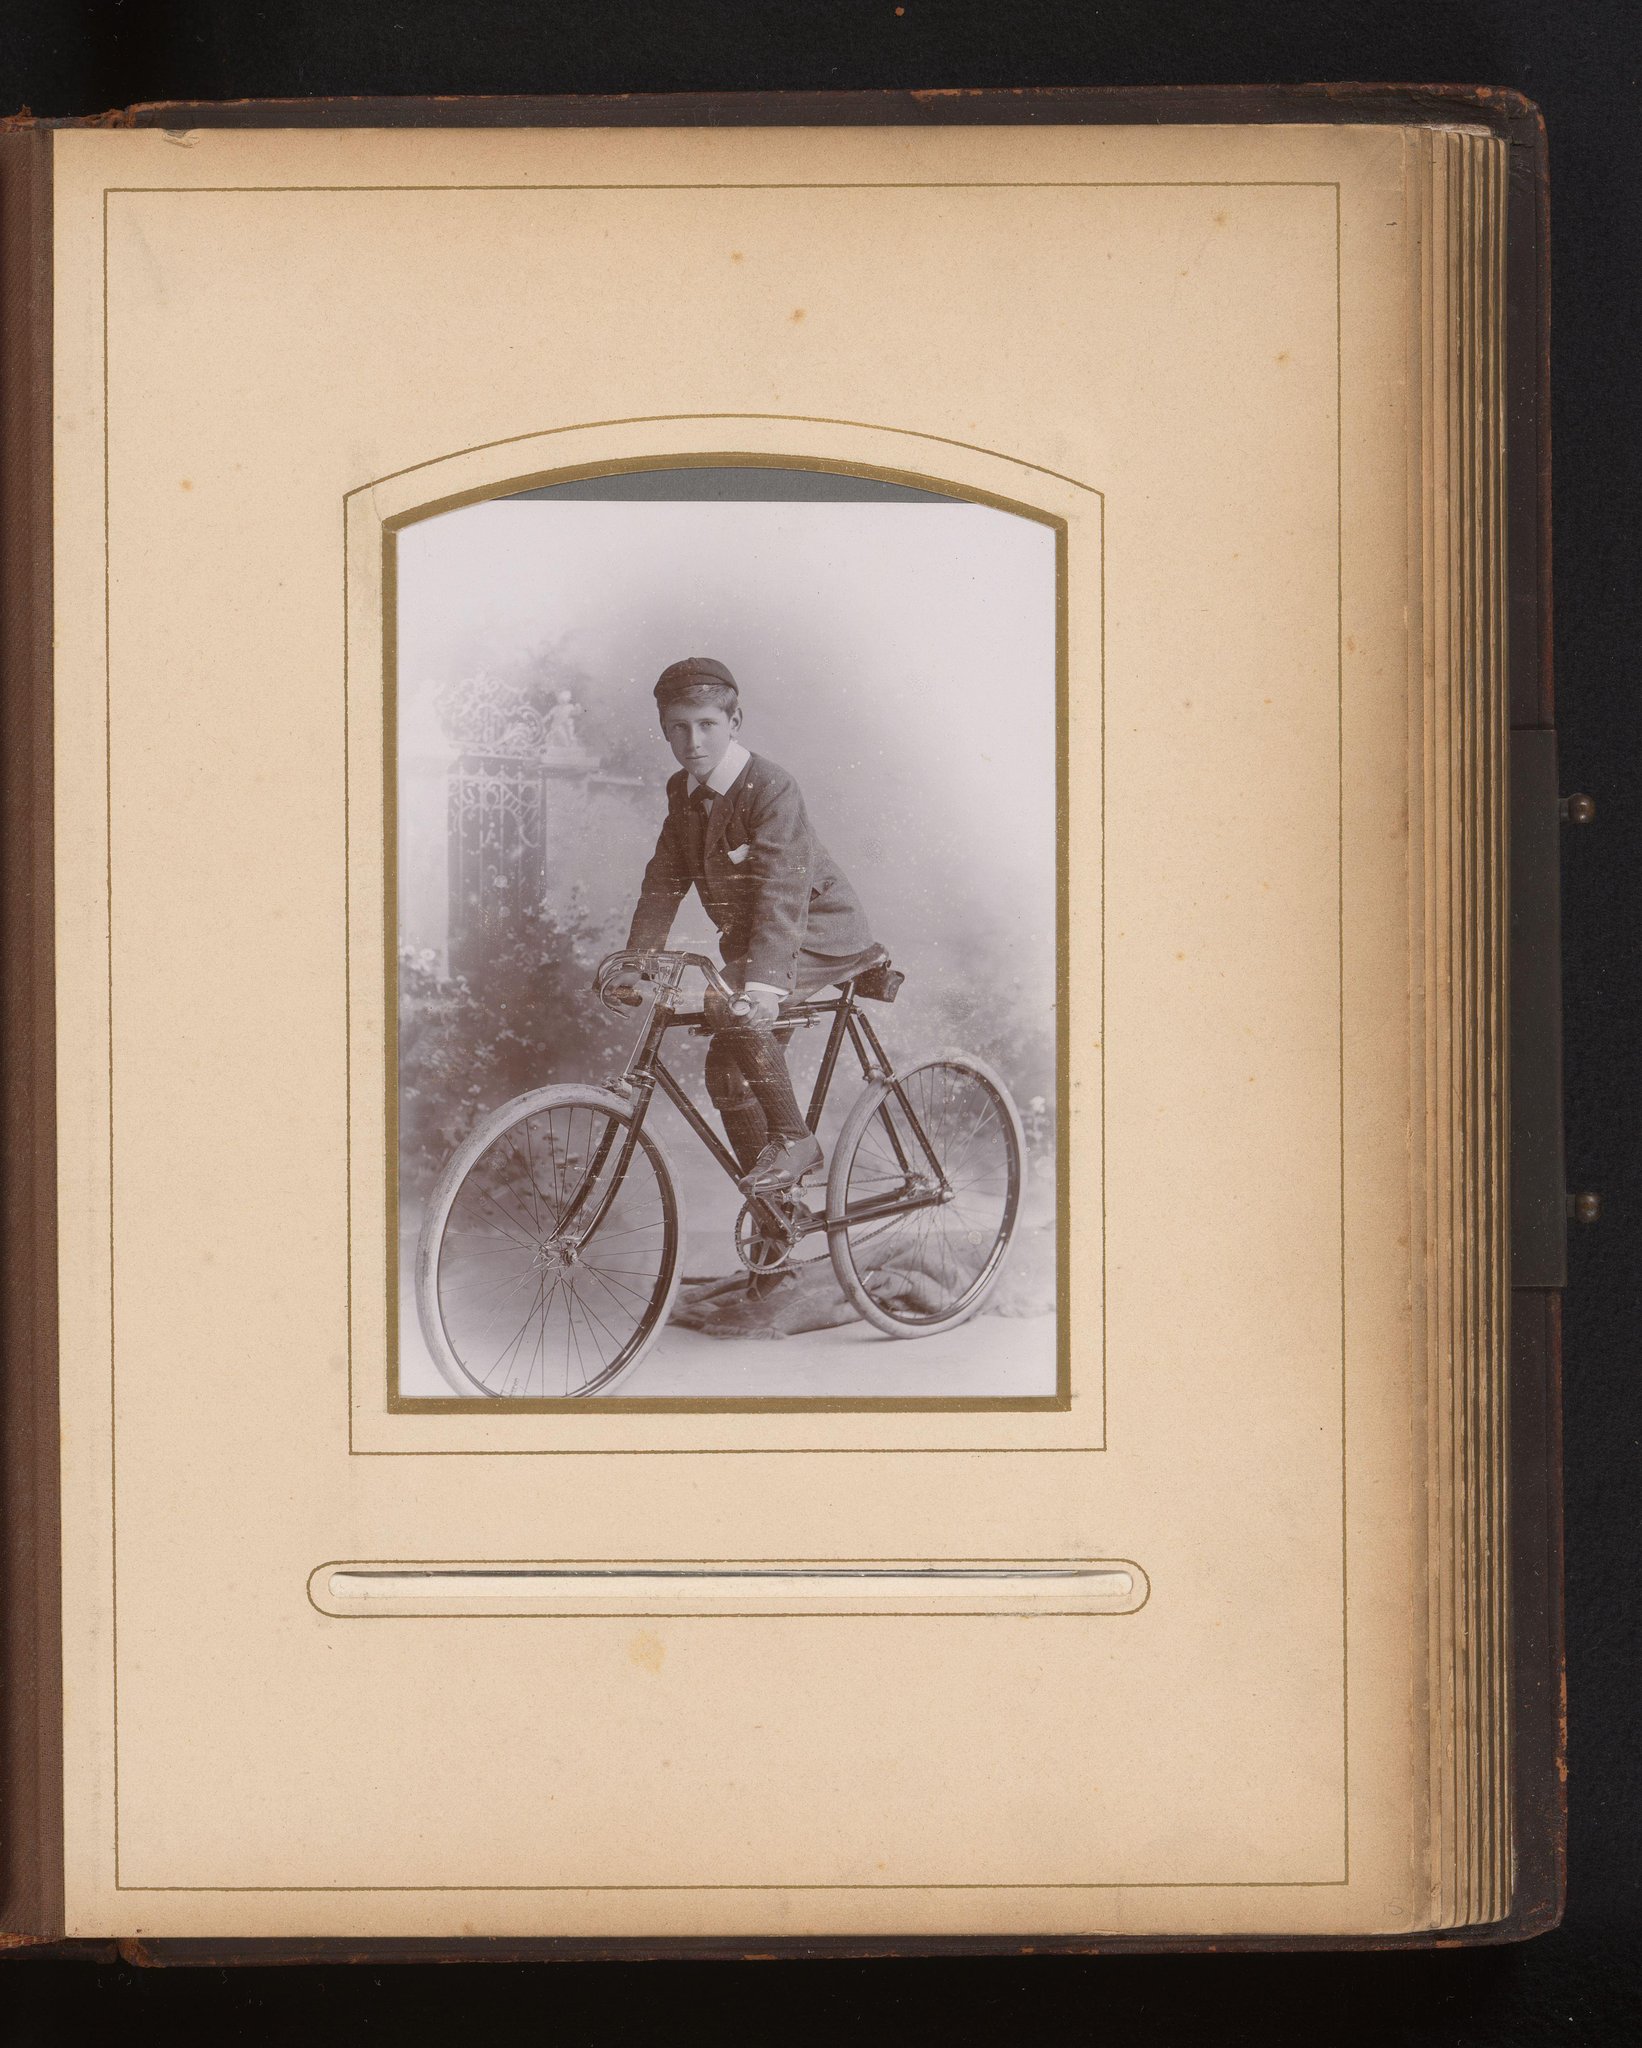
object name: cabinet photograph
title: Portret van een jongen op een fiets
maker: walter martin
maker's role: fotograaf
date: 1880-1920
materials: cardboard, photographic support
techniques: collodion silver print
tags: boy (child between toddler and youth), historical persons, bicycle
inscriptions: inscription: ‘Portrait & Landscape/ Phtotographer/ Walter Martin/ The Ilford Studio/ High Street/ Ilford’